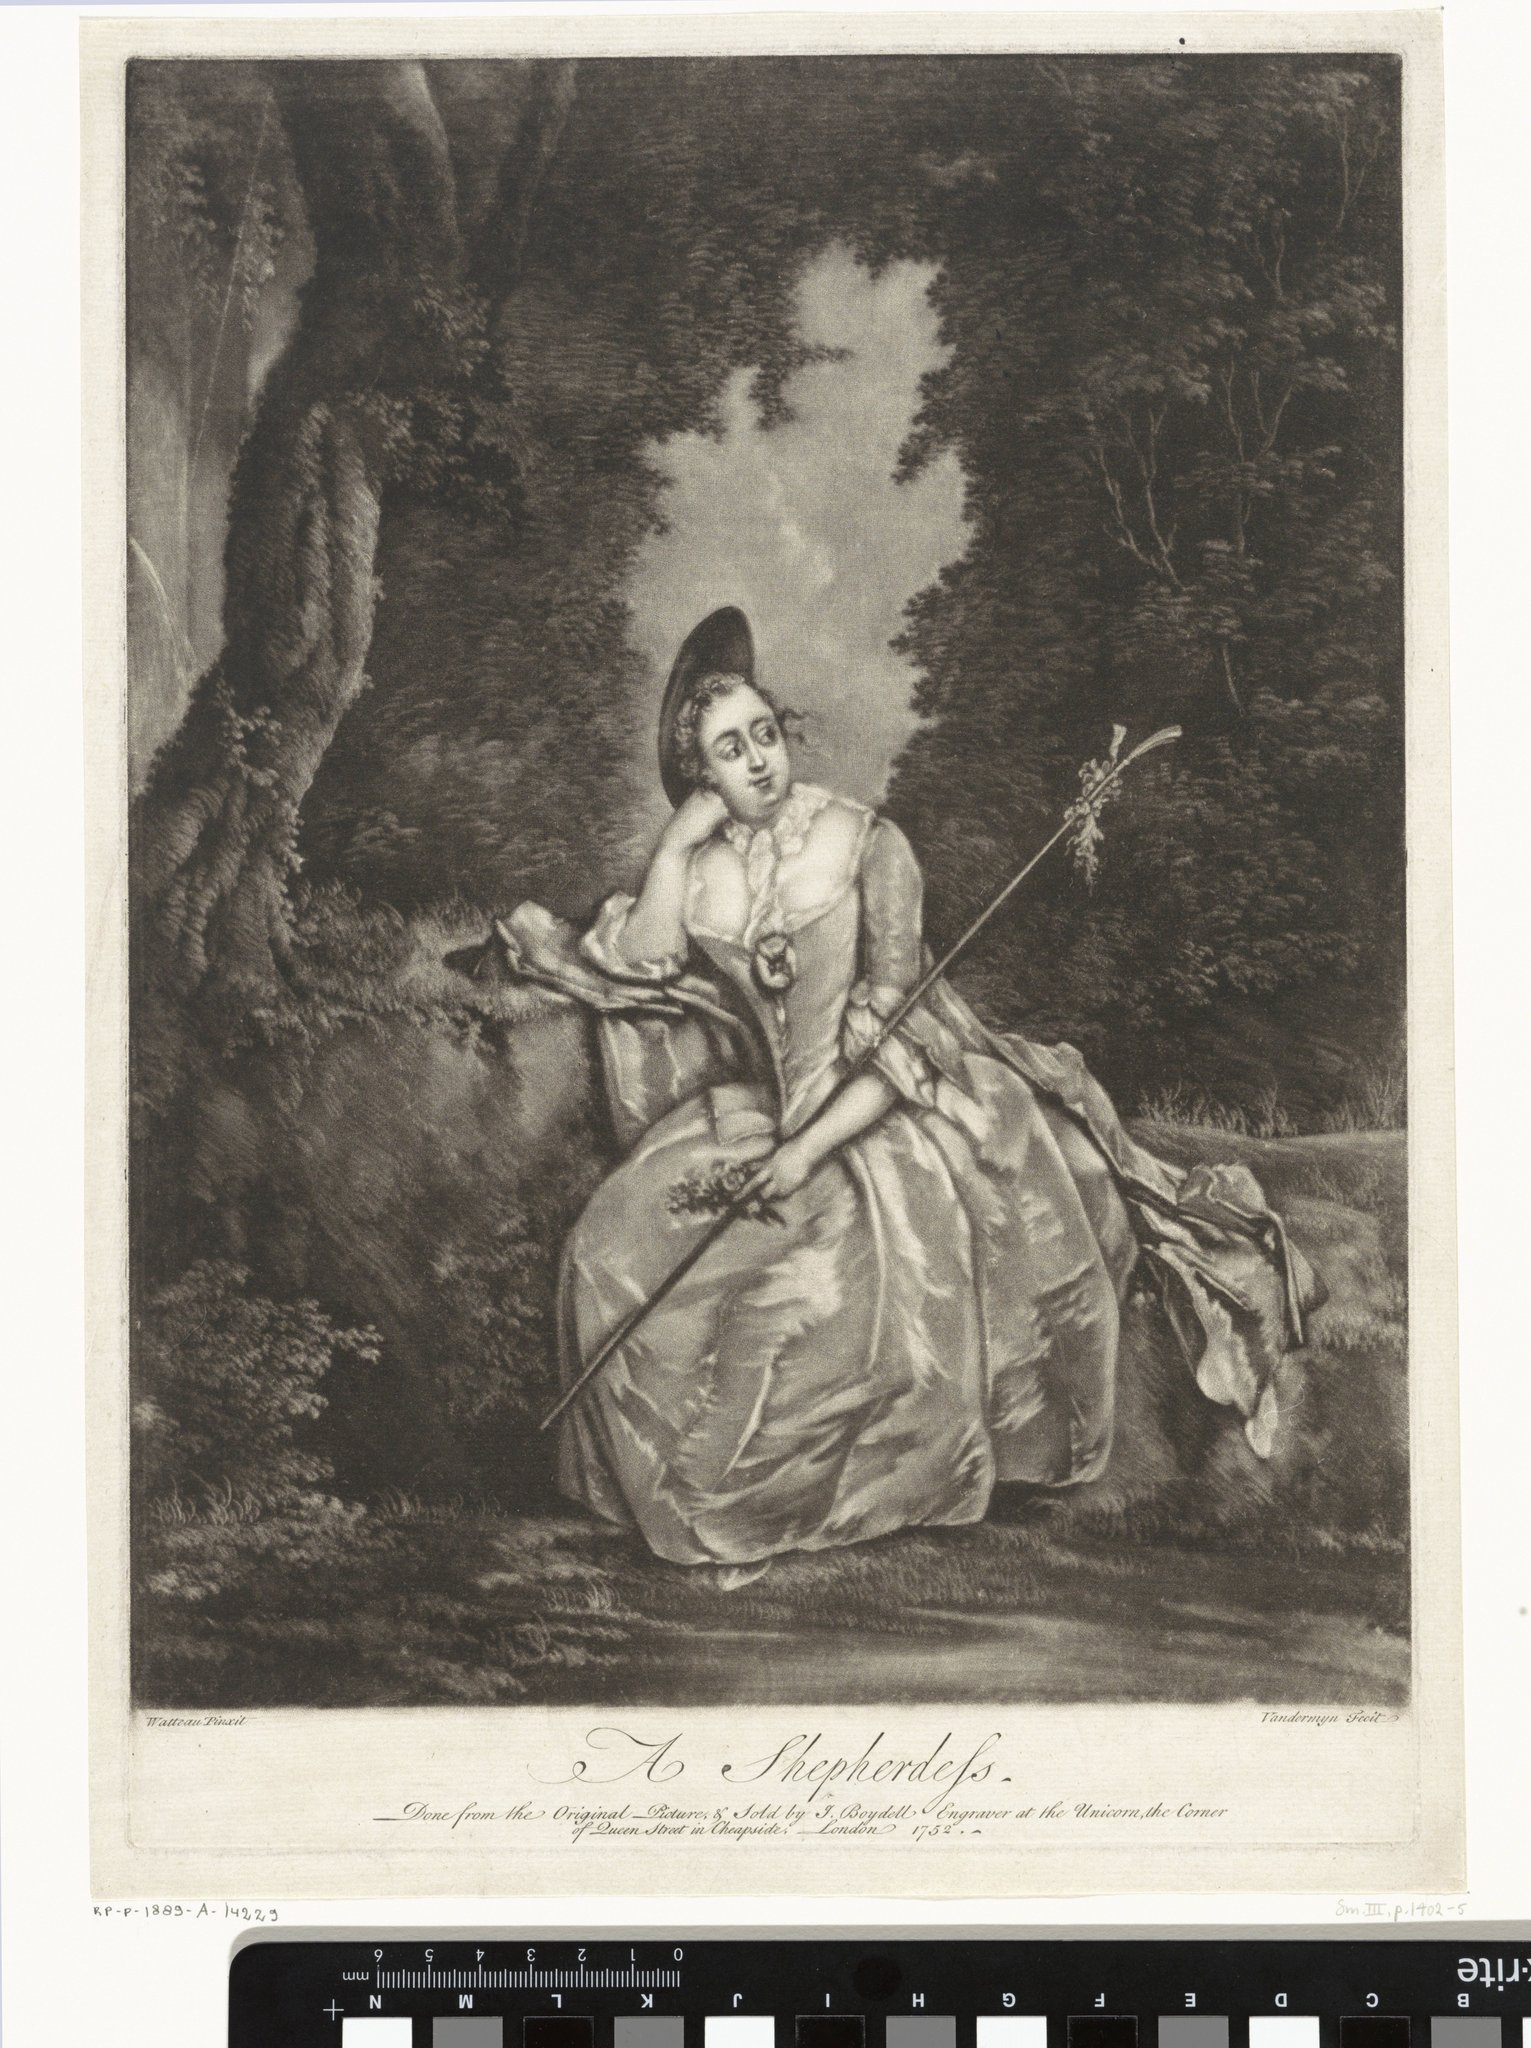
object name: print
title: A Shepherdess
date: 1752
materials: paper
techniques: engraving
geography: london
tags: herding, herdsman, herdswoman, shepherd, shepherdess, cowherd, etc., forest, wood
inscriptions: collector's mark: Lugt 2228, :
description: Een herderin zit onder een boom, een staf in de hand.